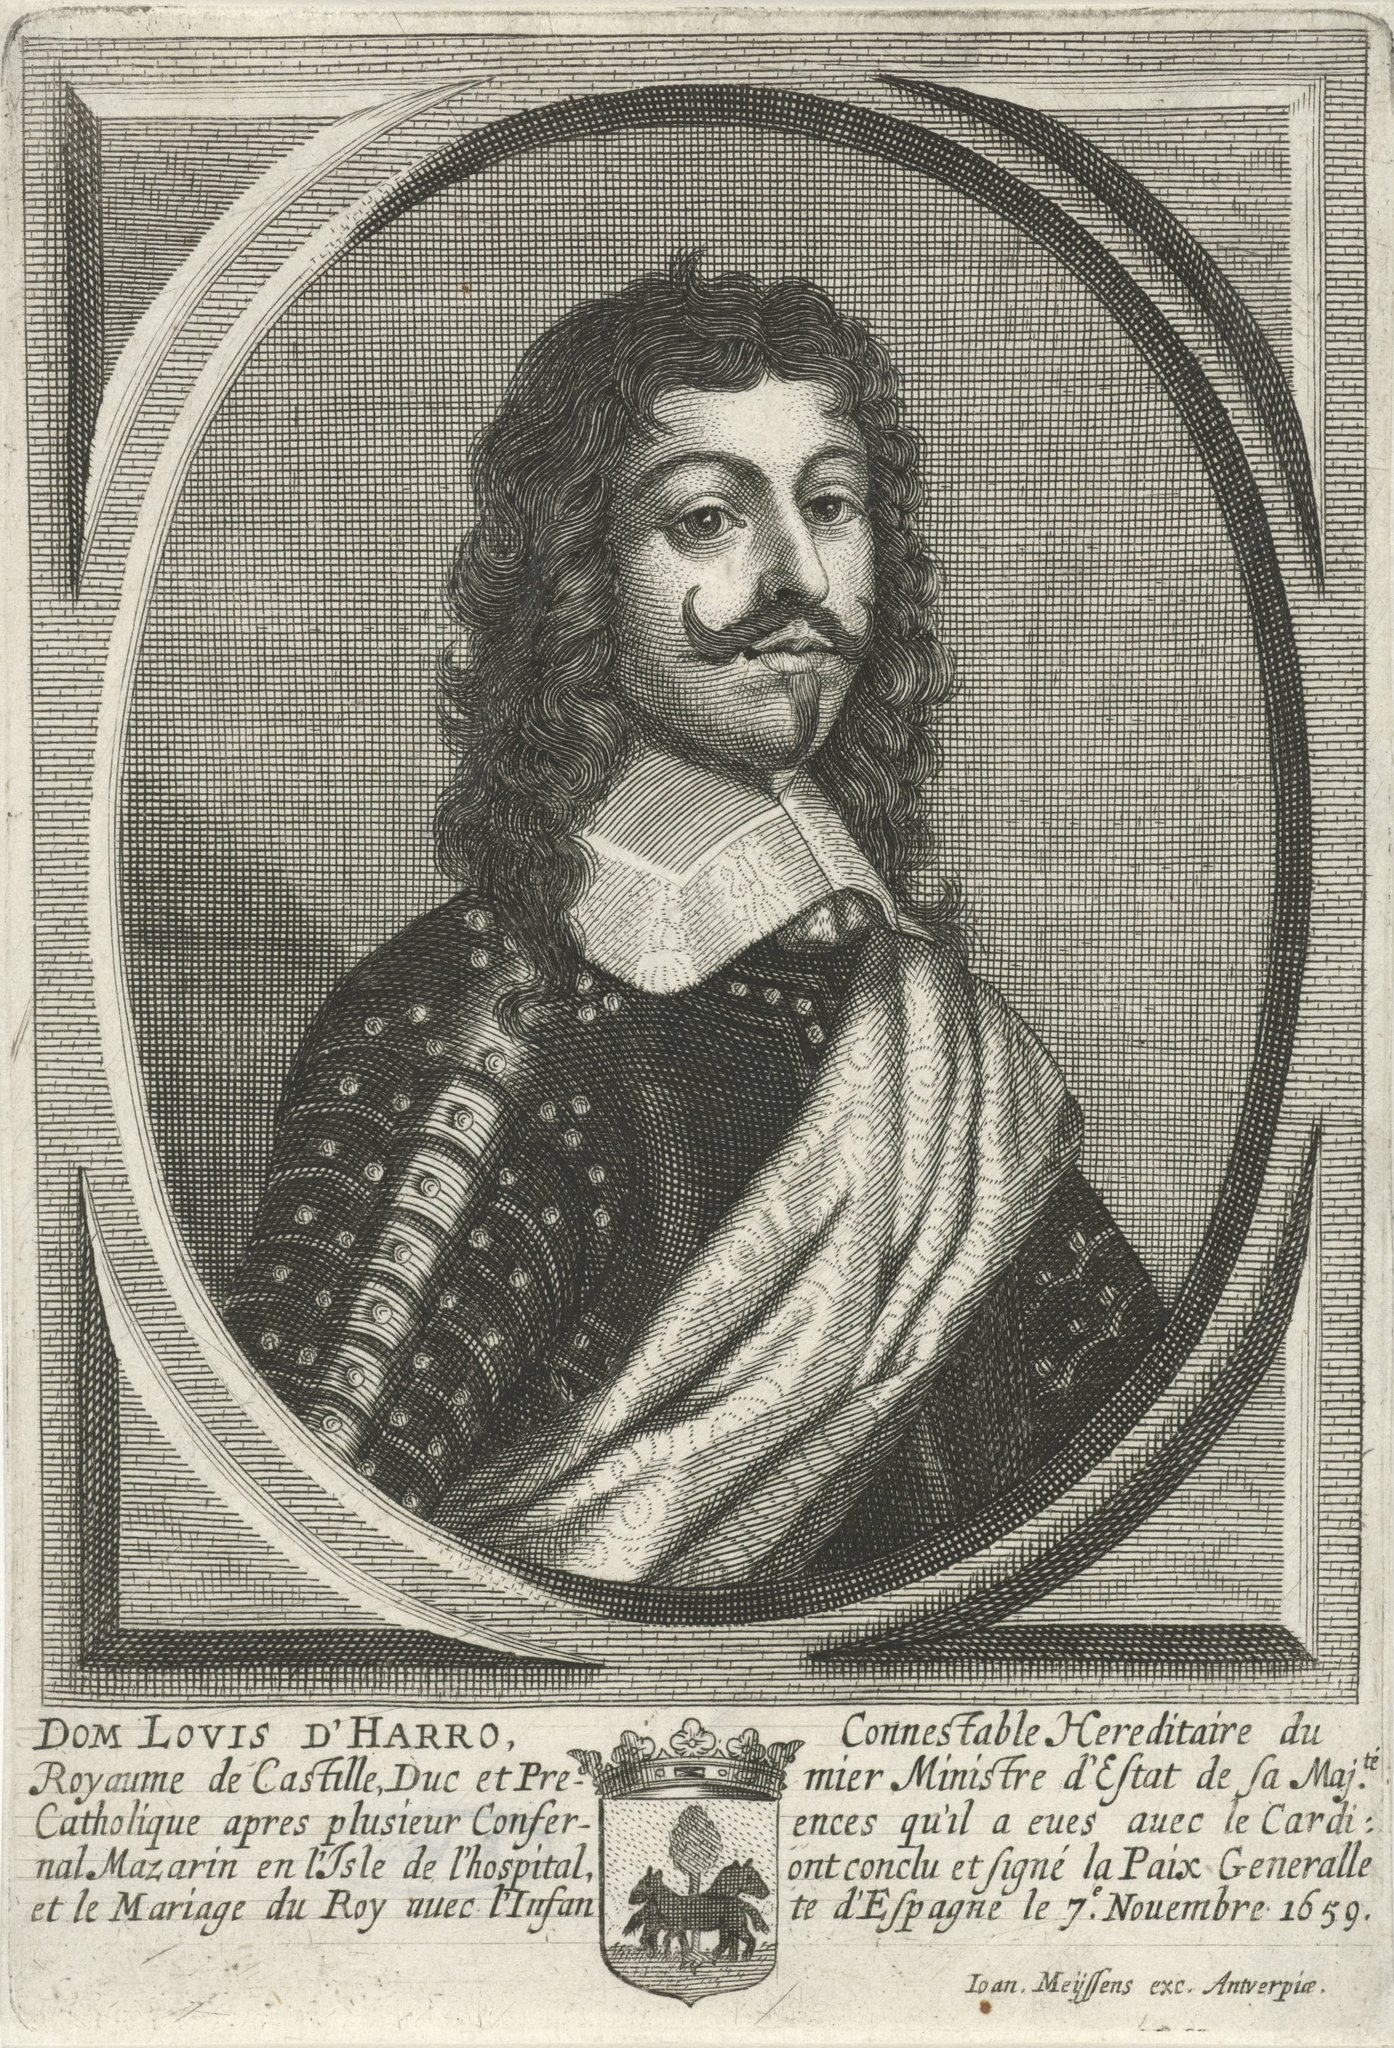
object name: print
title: Portret van Lius Méndez de Haro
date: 1650-1670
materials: paper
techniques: engraving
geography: antwerp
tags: politician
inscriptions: collector's mark: Lugt 2228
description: Portret van Lius Méndez de Haro. Onderaan in de marge zijn wapenschild en een vijfregelige tekst in het Frans.